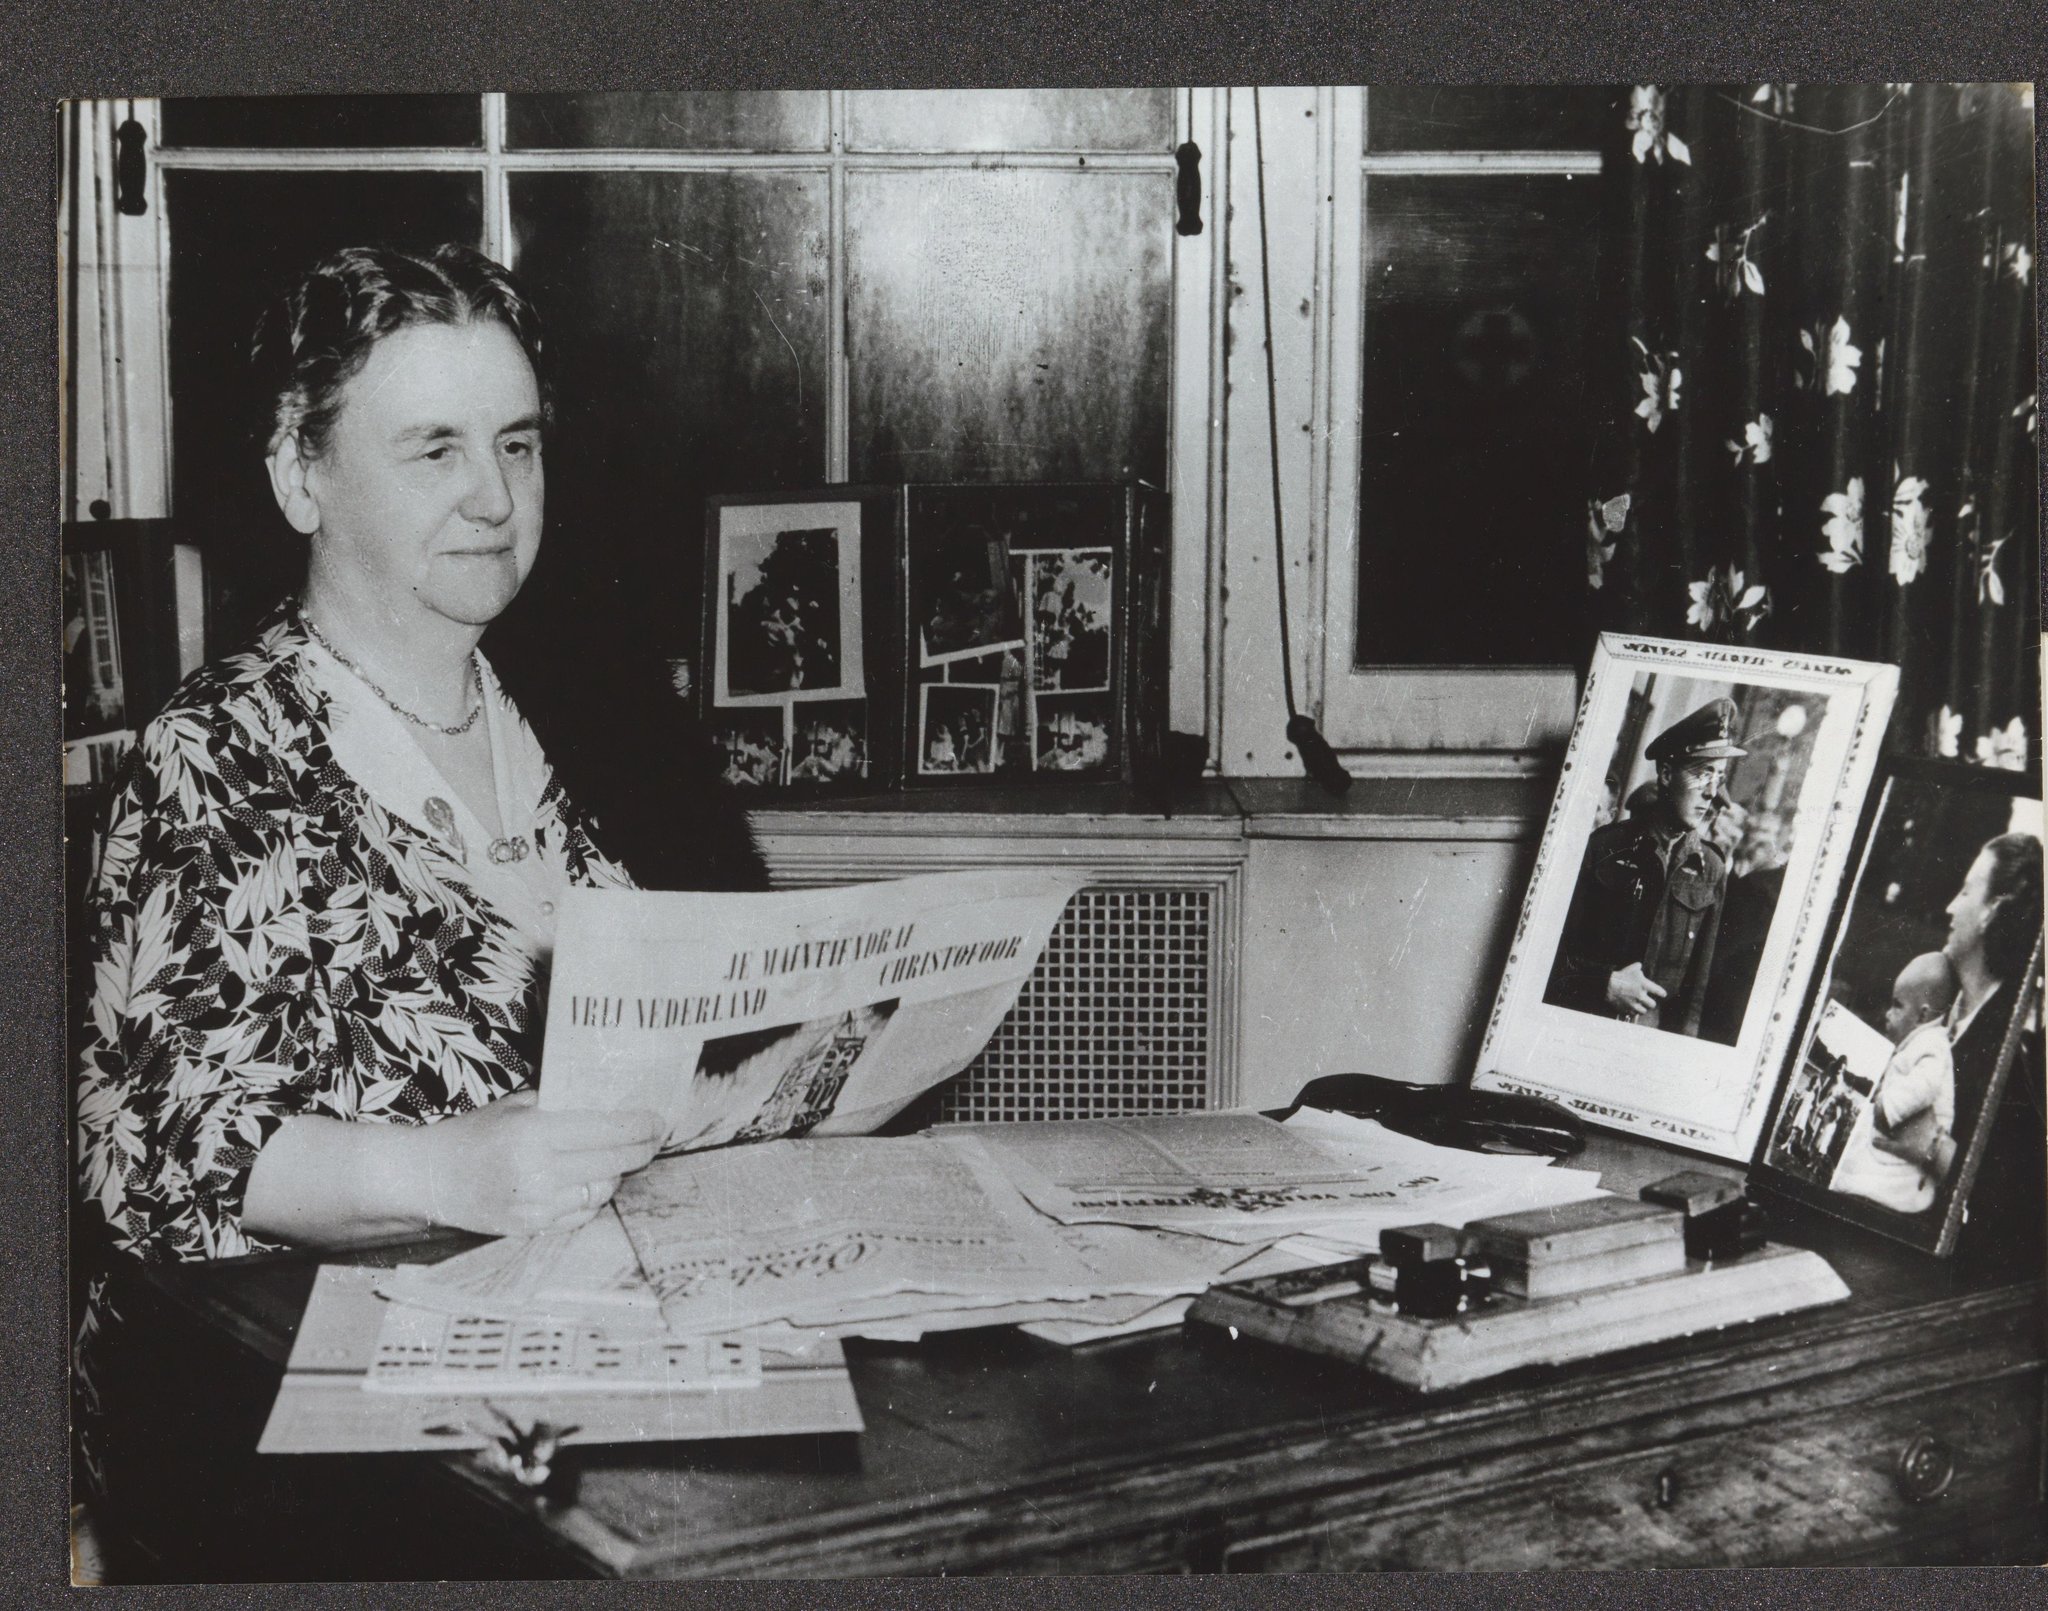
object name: photograph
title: Koningin Wilhelmina leest een Nederlands verzetsblad in haar werkkamer in Londen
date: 1945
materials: photographic support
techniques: gelatin silver print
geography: amsterdam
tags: london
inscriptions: inscription: ‘foto: koningin Wilhelmina in de oorlogsjaren 1940-1945 in haar werkkamer in Londen, terwijl zij de Nederlandse verzetsbalden leest’, inscription: ‘april 1945 Londen, een der laatste foto's van Wilhelmina in londen’, stamp: ‘copyright Anefo no 9575’